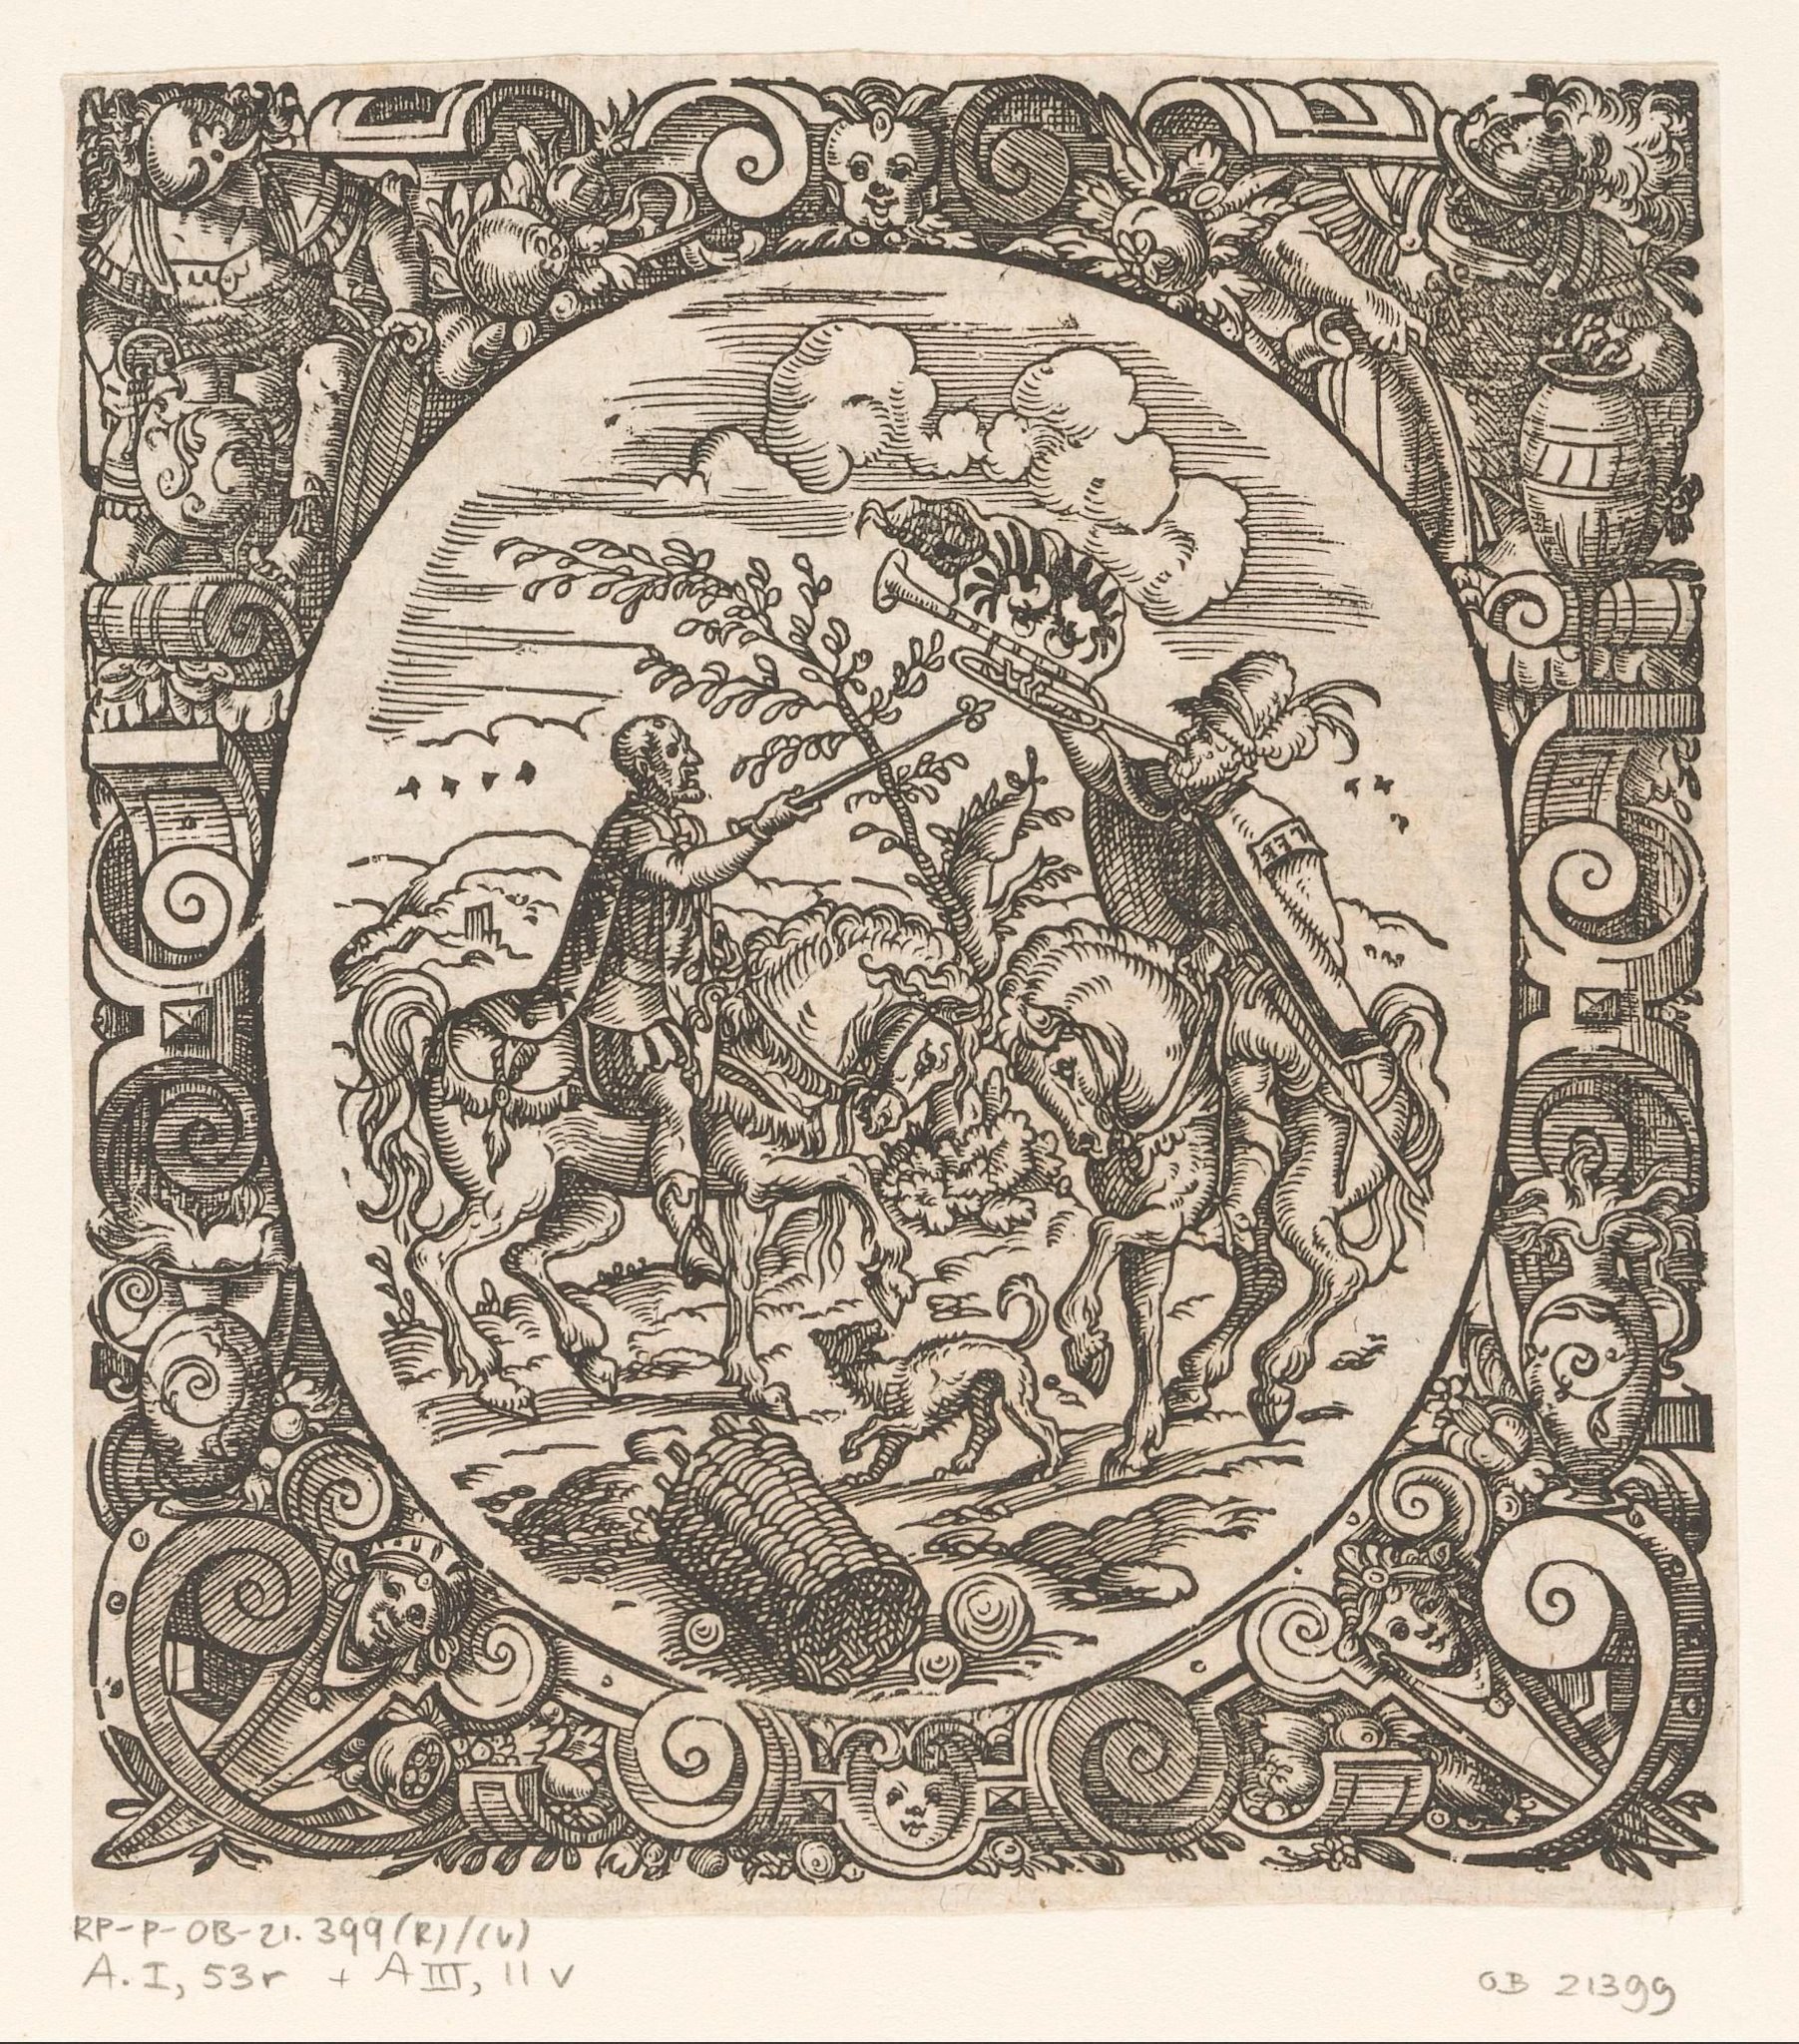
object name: print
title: Heraut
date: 1573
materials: paper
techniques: woodcut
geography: nuremberg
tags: messenger, warfare; military affairs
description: Zowel de voorstelling als de ornamentrand werd gebruikt voor verschillende edities van Leonhardt Fronspergers Kriegsbuch.